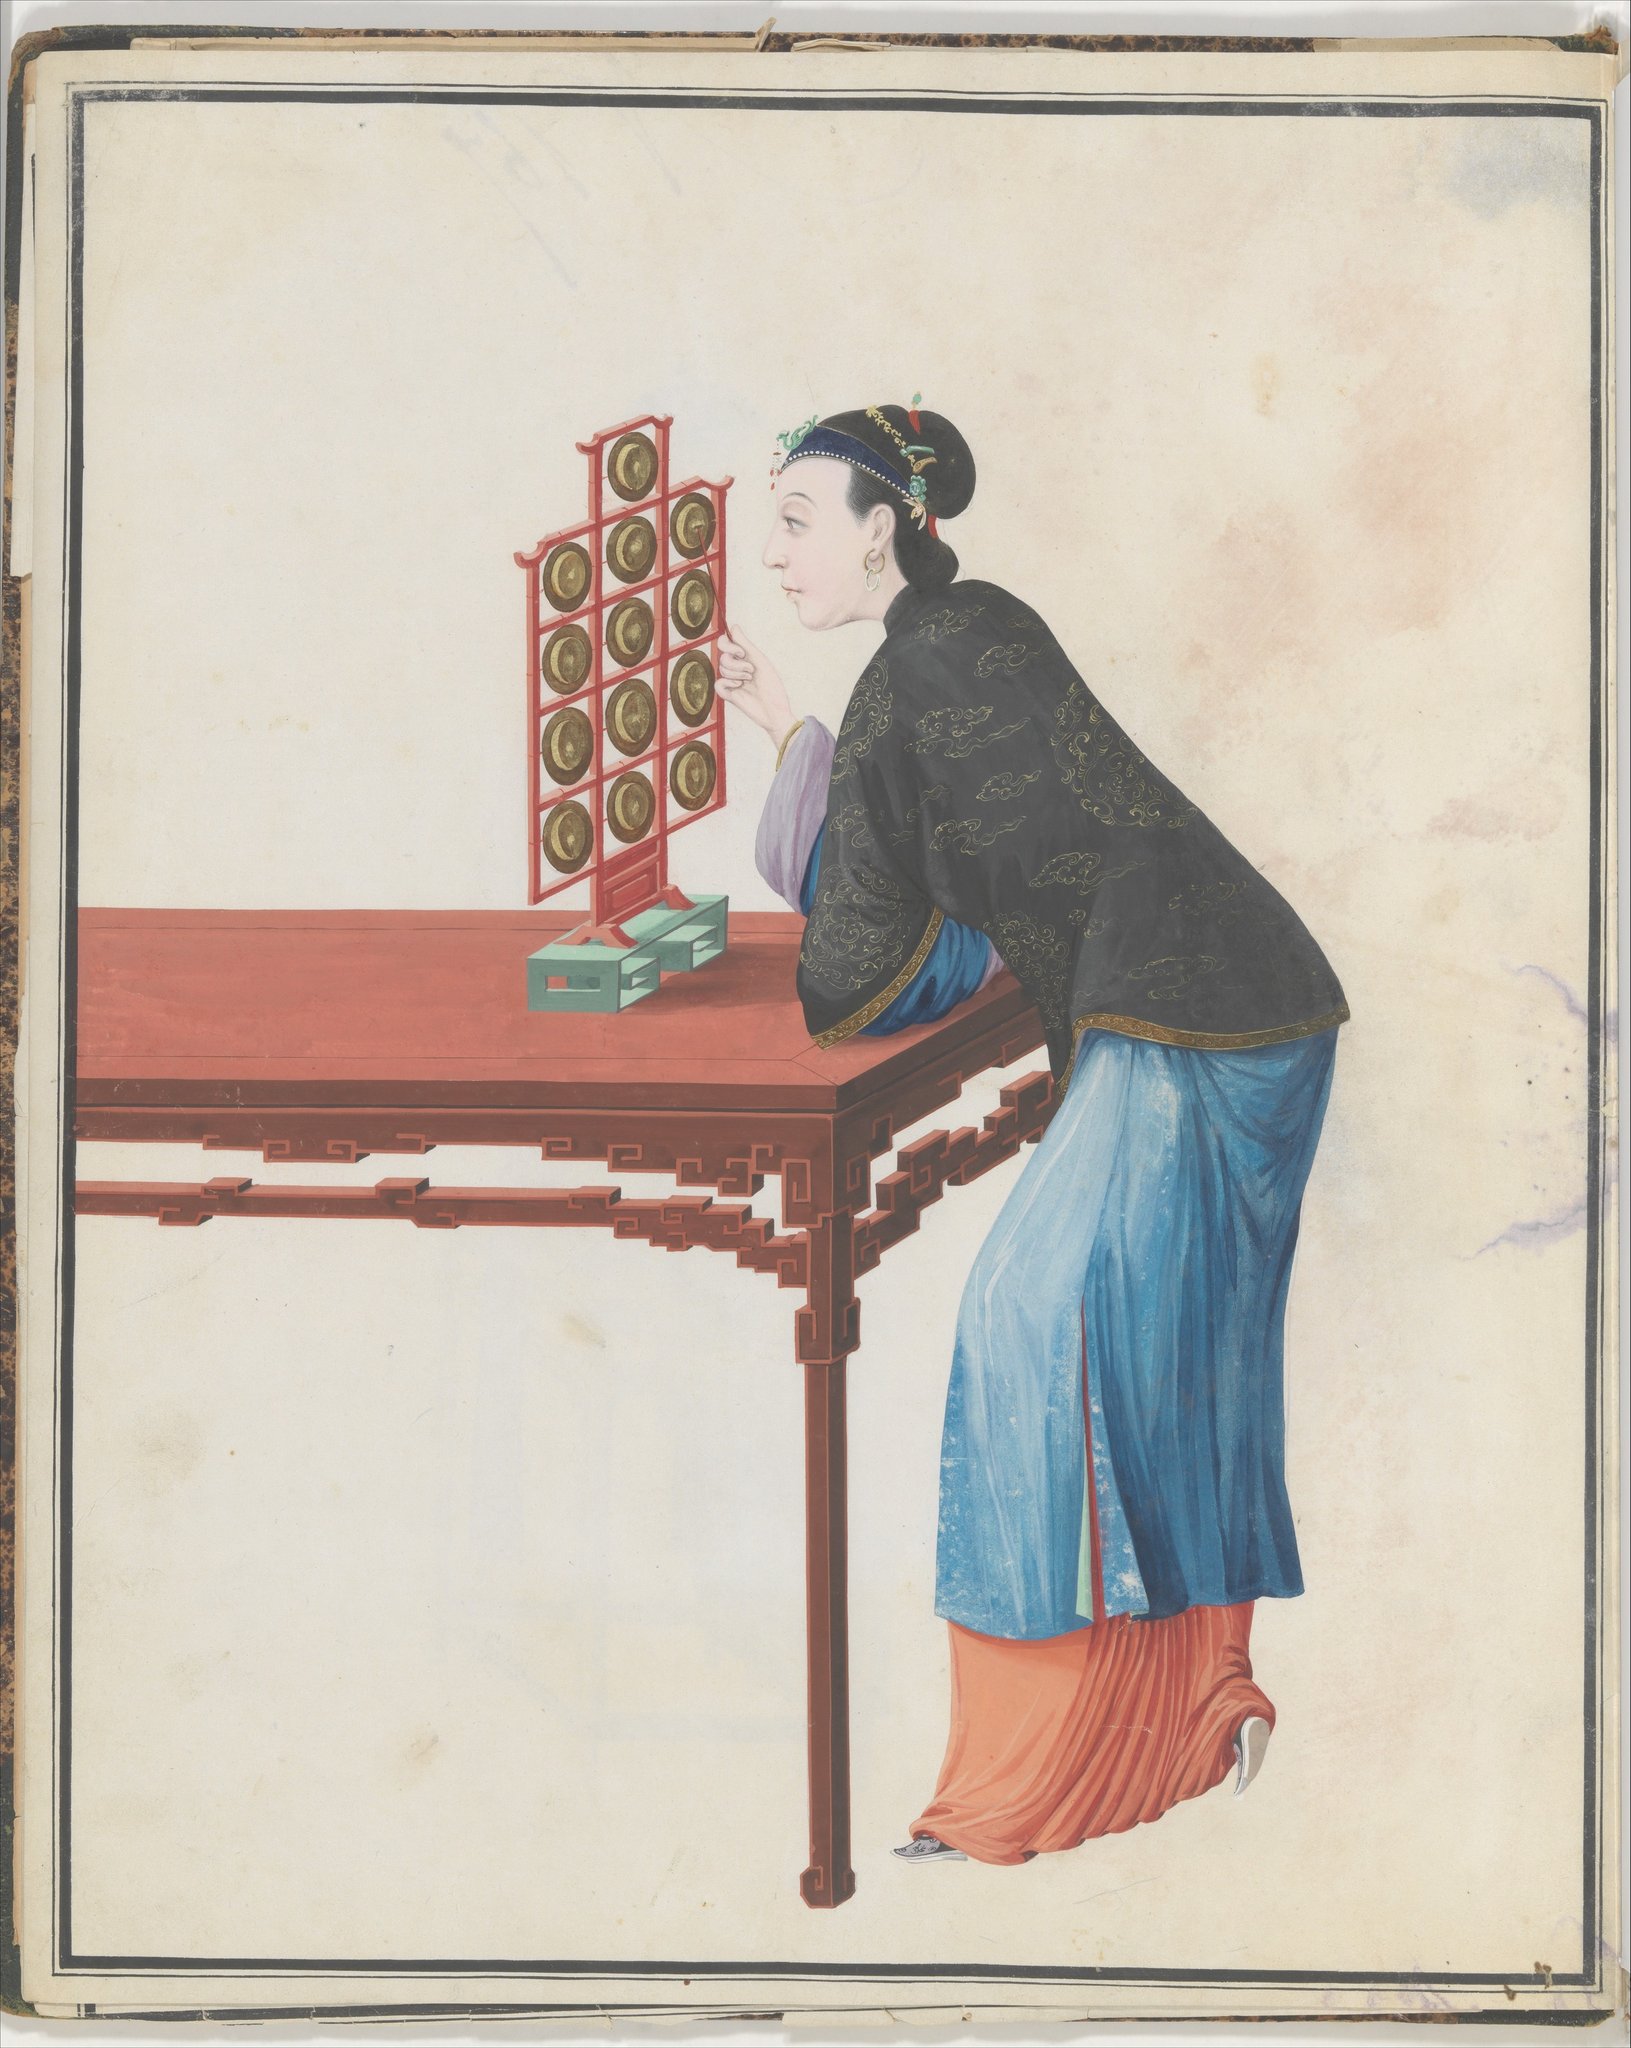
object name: watercolor of musician playing yunlo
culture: chinese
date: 1767-1800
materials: paper, watercolor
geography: china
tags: musical instruments,women,musicians